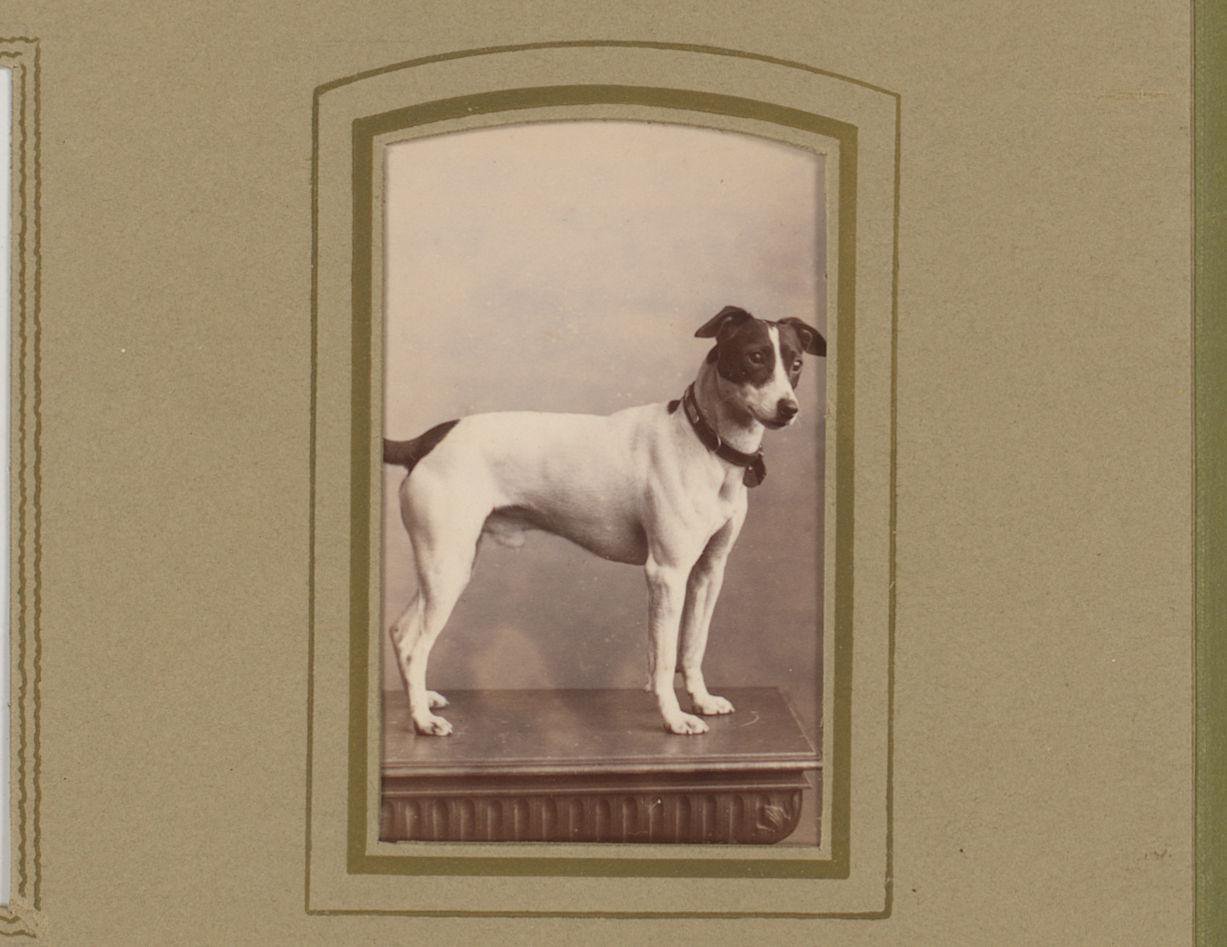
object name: photograph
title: Hond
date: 1857-1908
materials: cardboard, photographic support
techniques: albumen print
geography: amsterdam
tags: dog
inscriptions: inscription: ‘Woodbury & Page/ AMSTERDAM/ DAMSTRAAT 23/ EN/ BATAVIA.’